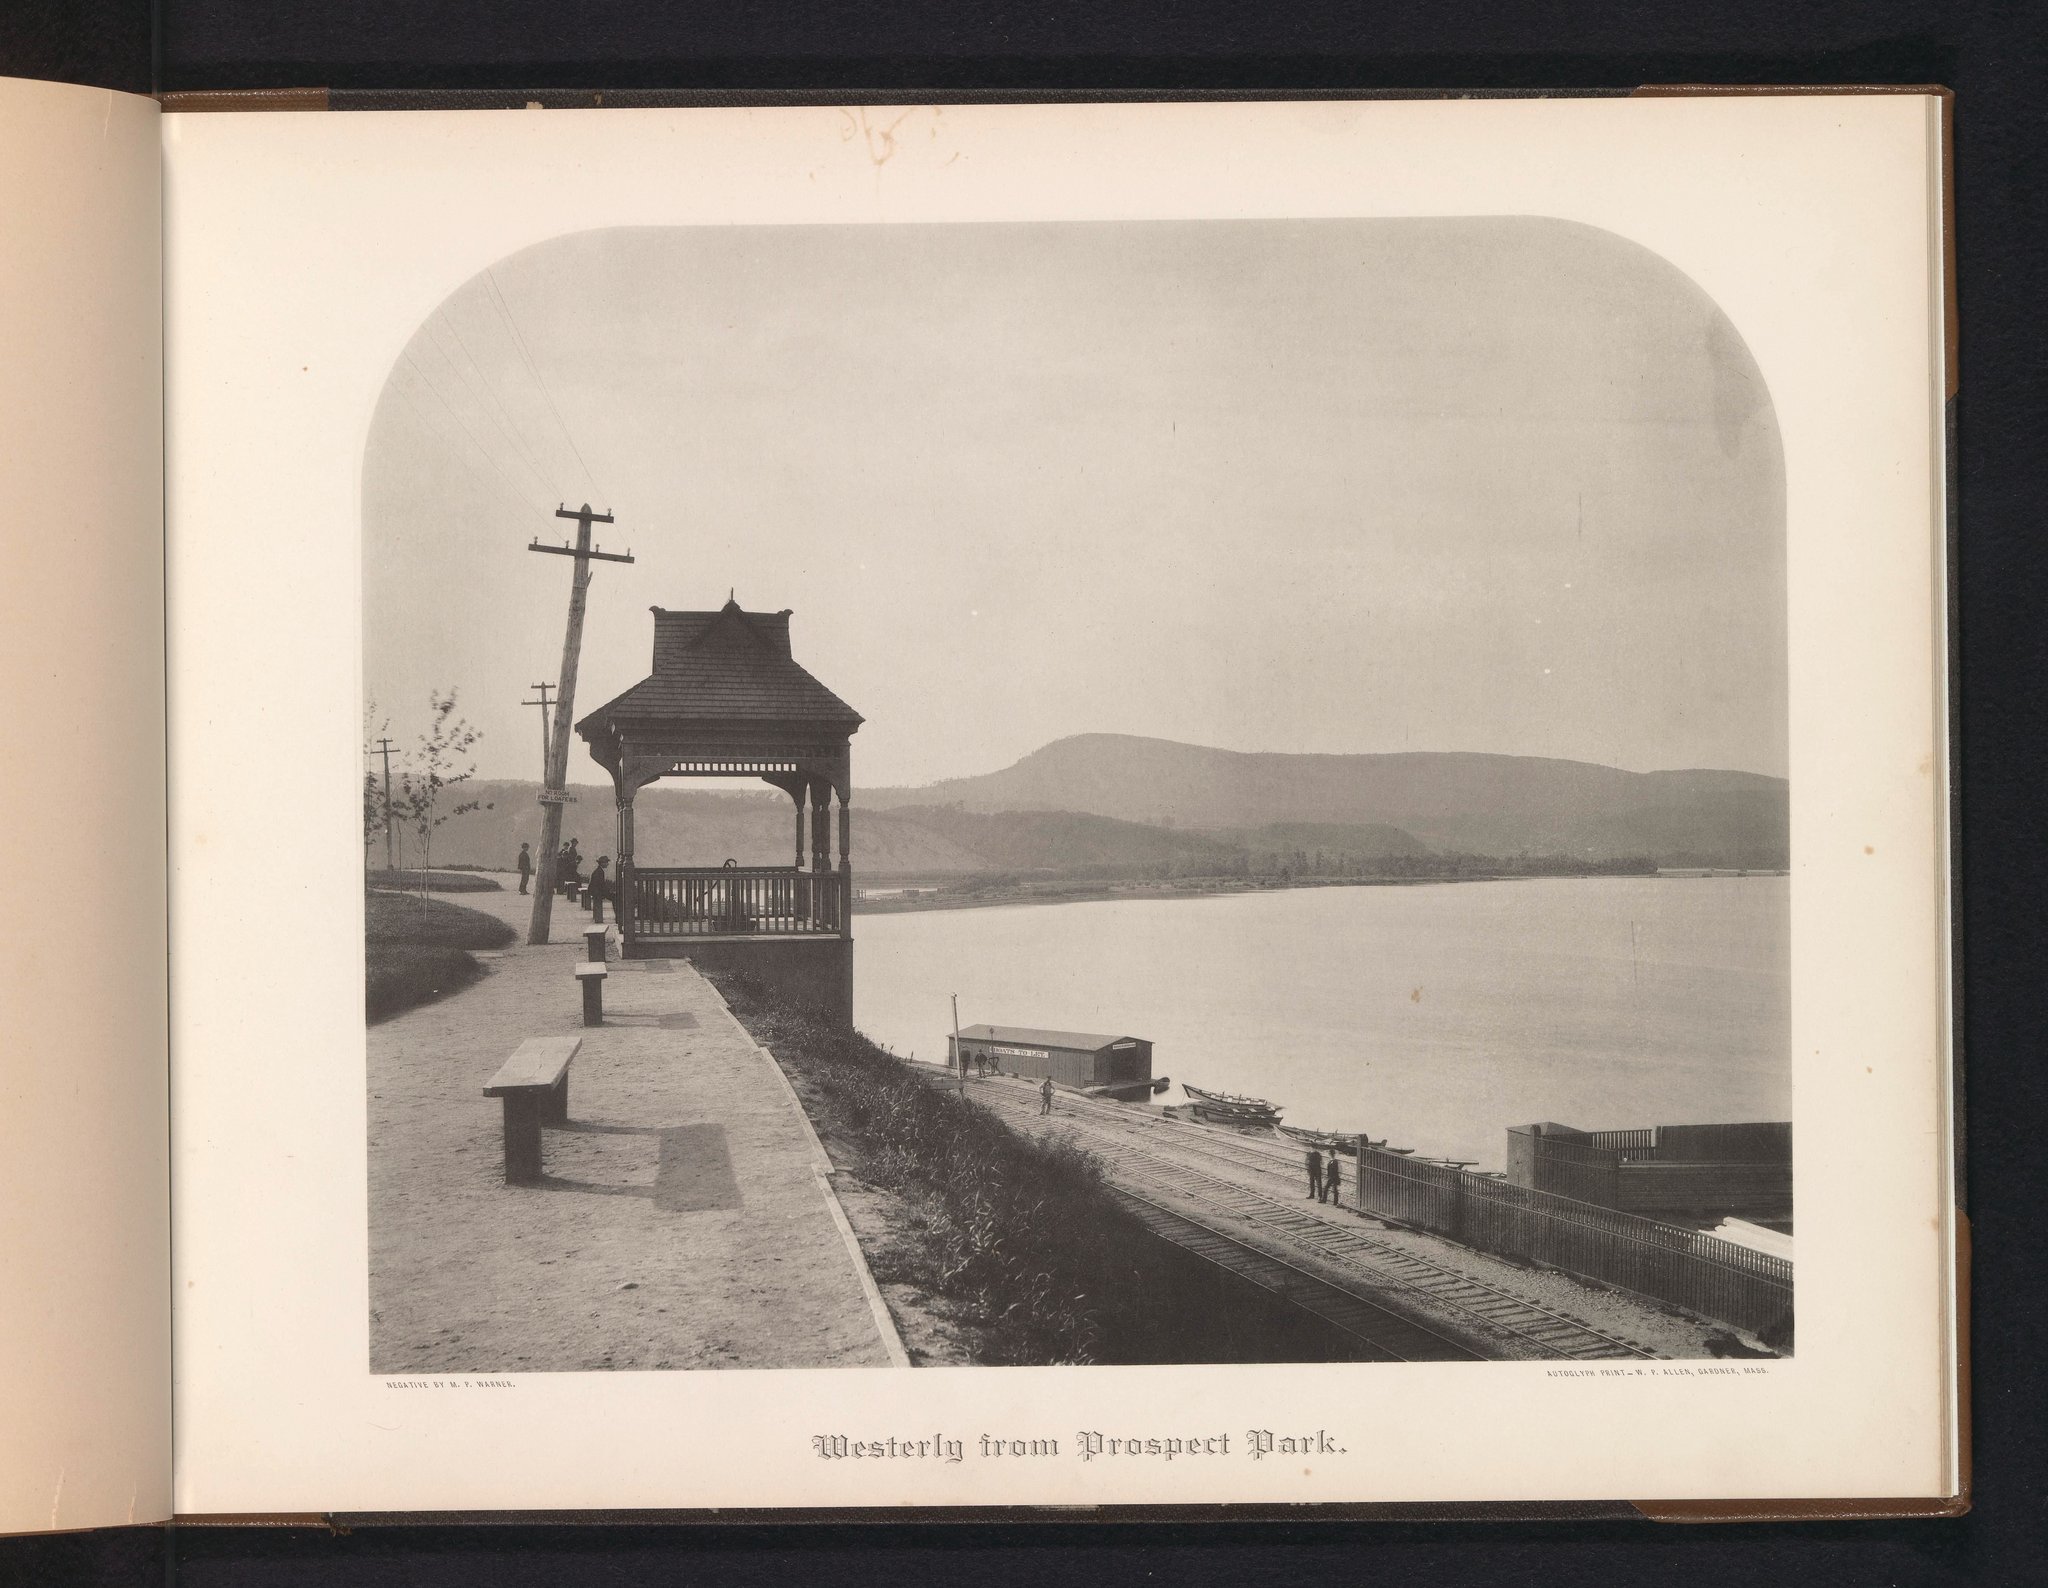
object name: photomechanical print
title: Westerly from Prospect Park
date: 1883-1888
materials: paper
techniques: photograph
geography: massachusetts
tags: river